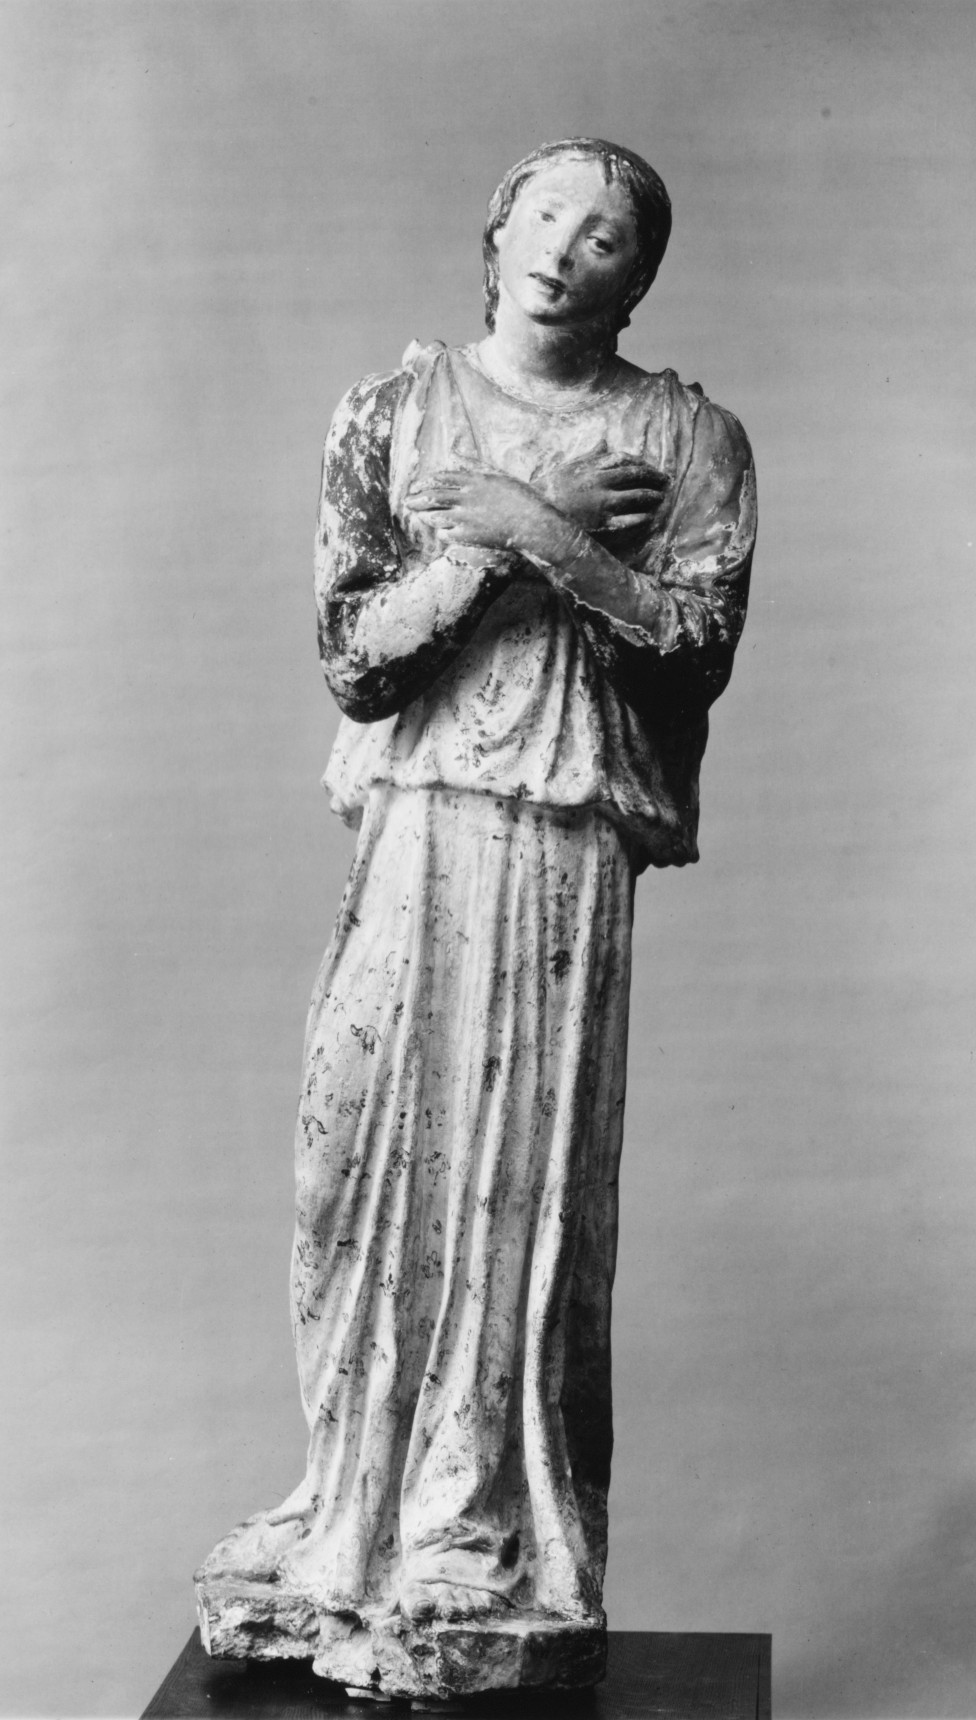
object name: statue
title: The Angel Gabriel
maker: masseo civitali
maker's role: artist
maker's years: 1459-1541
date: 1493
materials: gilt, terracotta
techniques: painting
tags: archangel gabriel